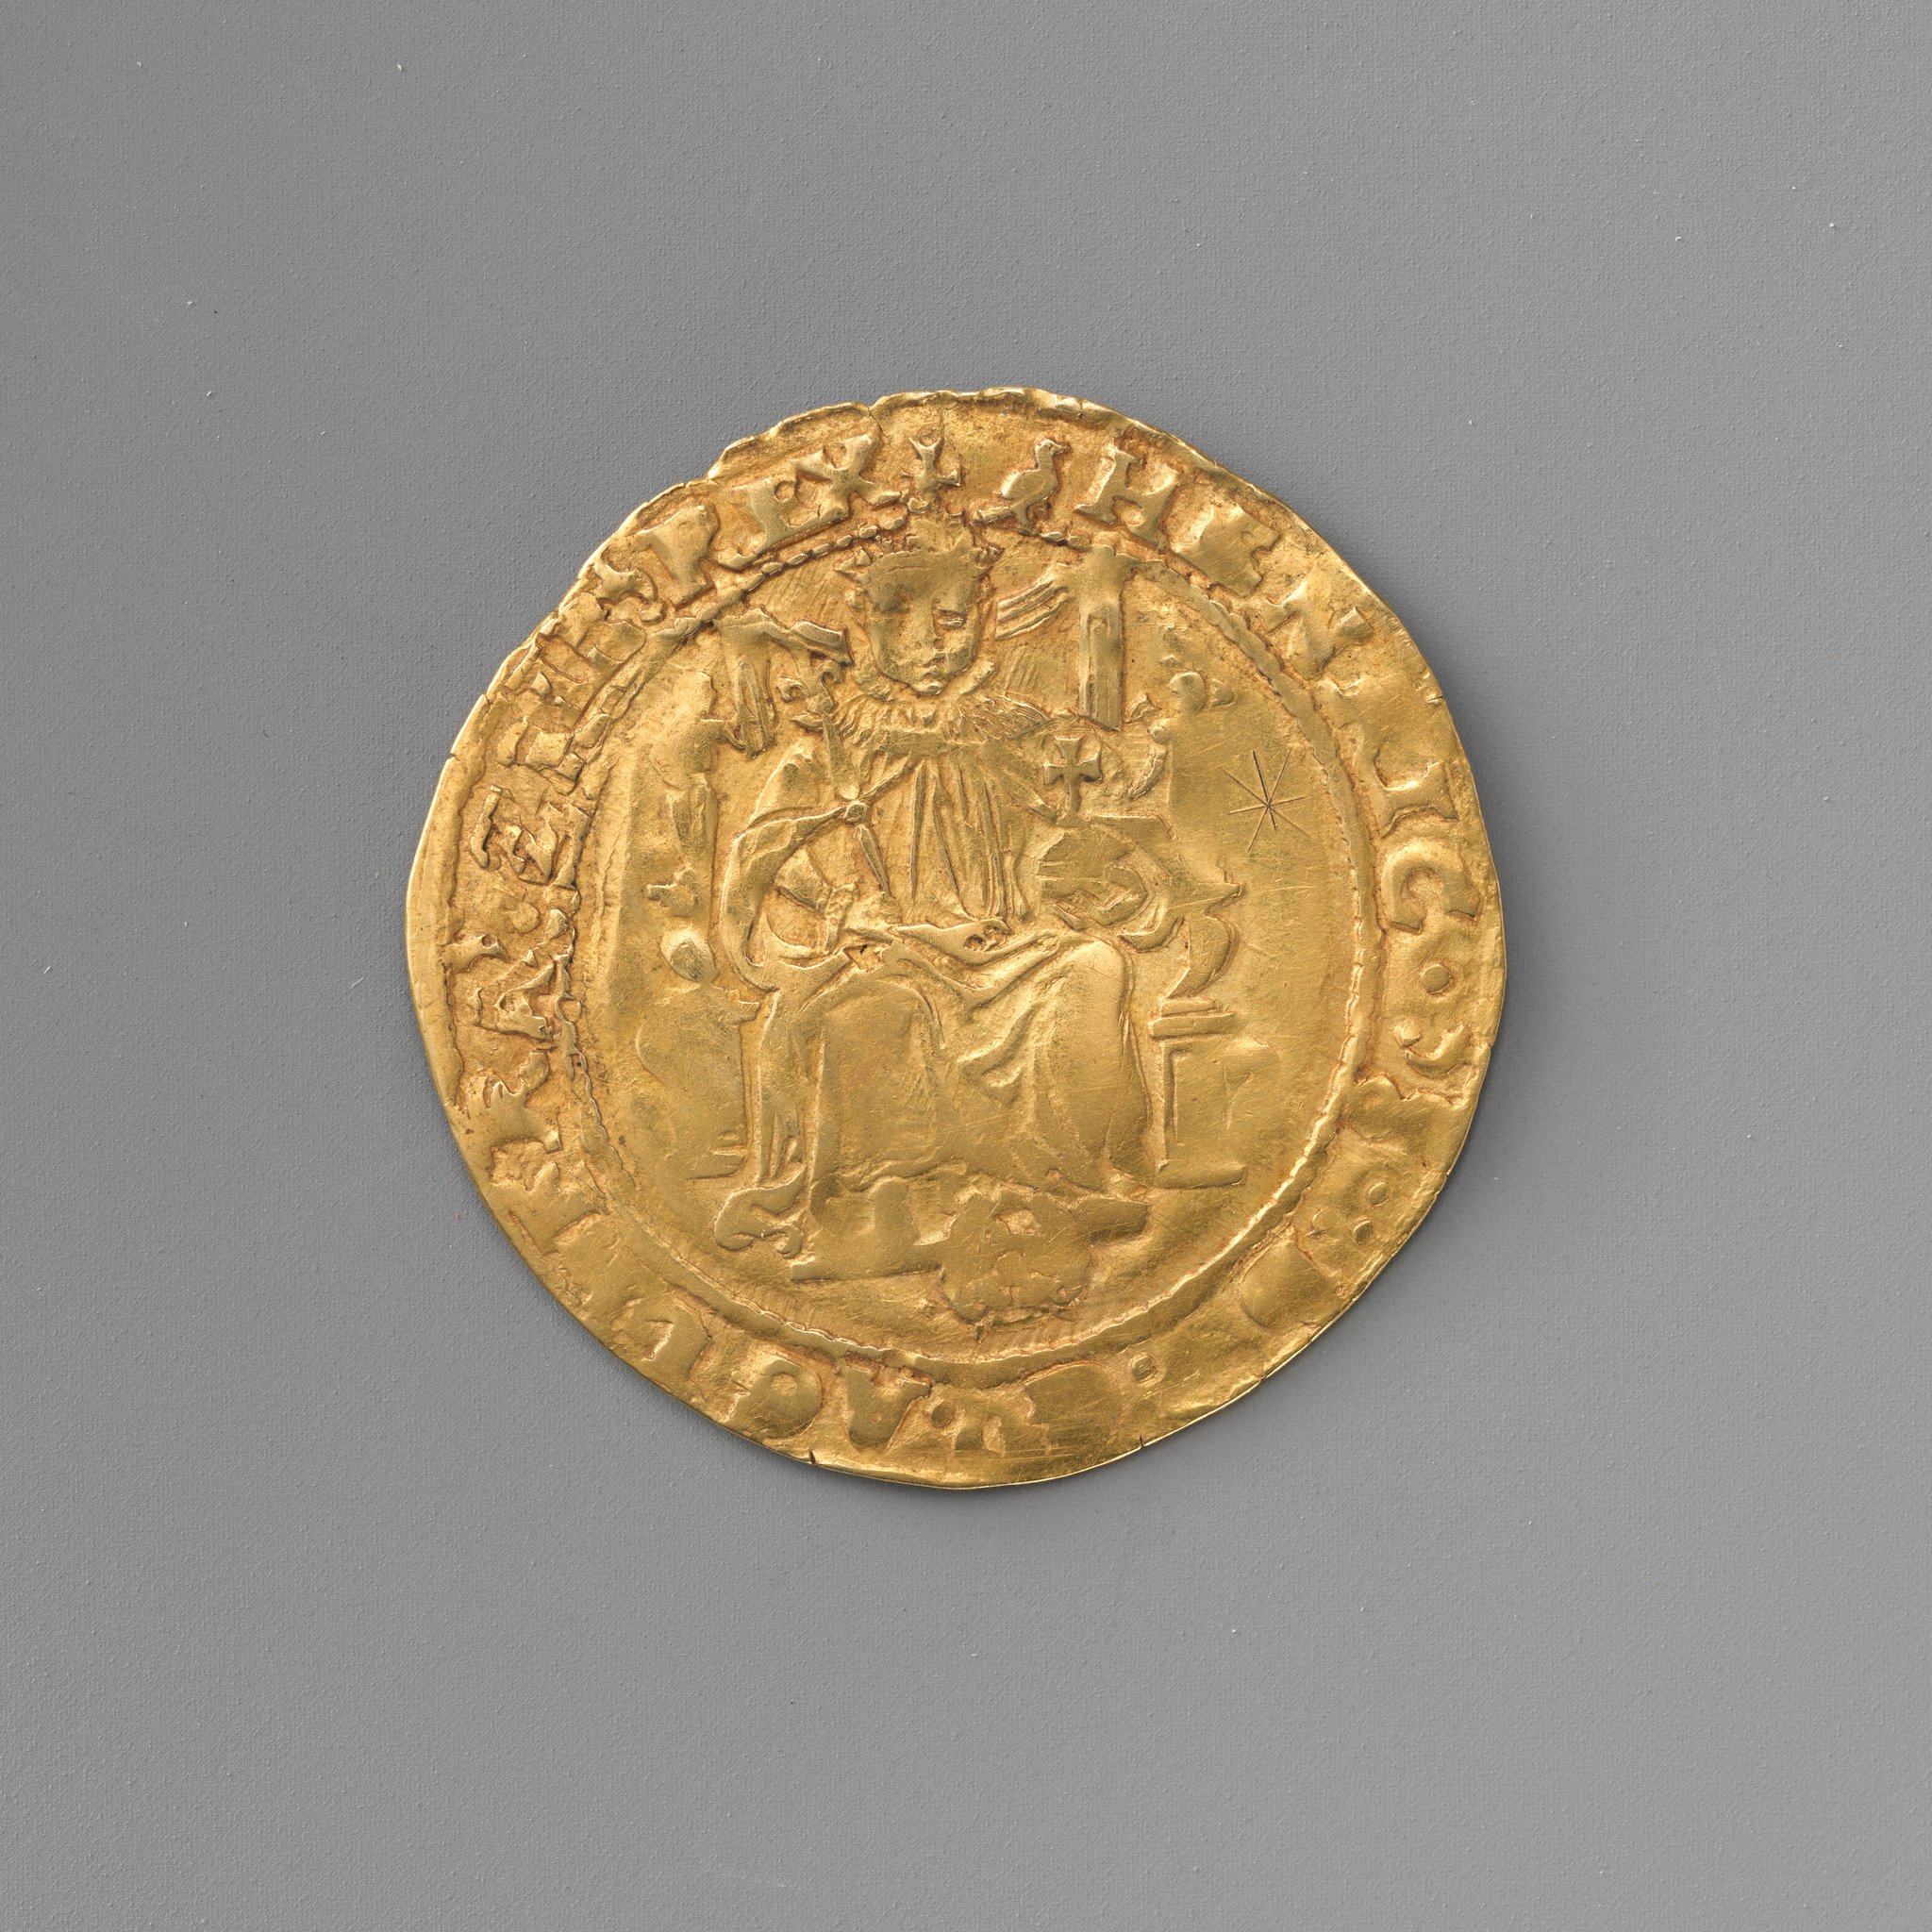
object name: half sovereign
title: Half sovereign of Henry VIII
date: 1547-1550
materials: gold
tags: henry viii,kings,coins,coat of arms